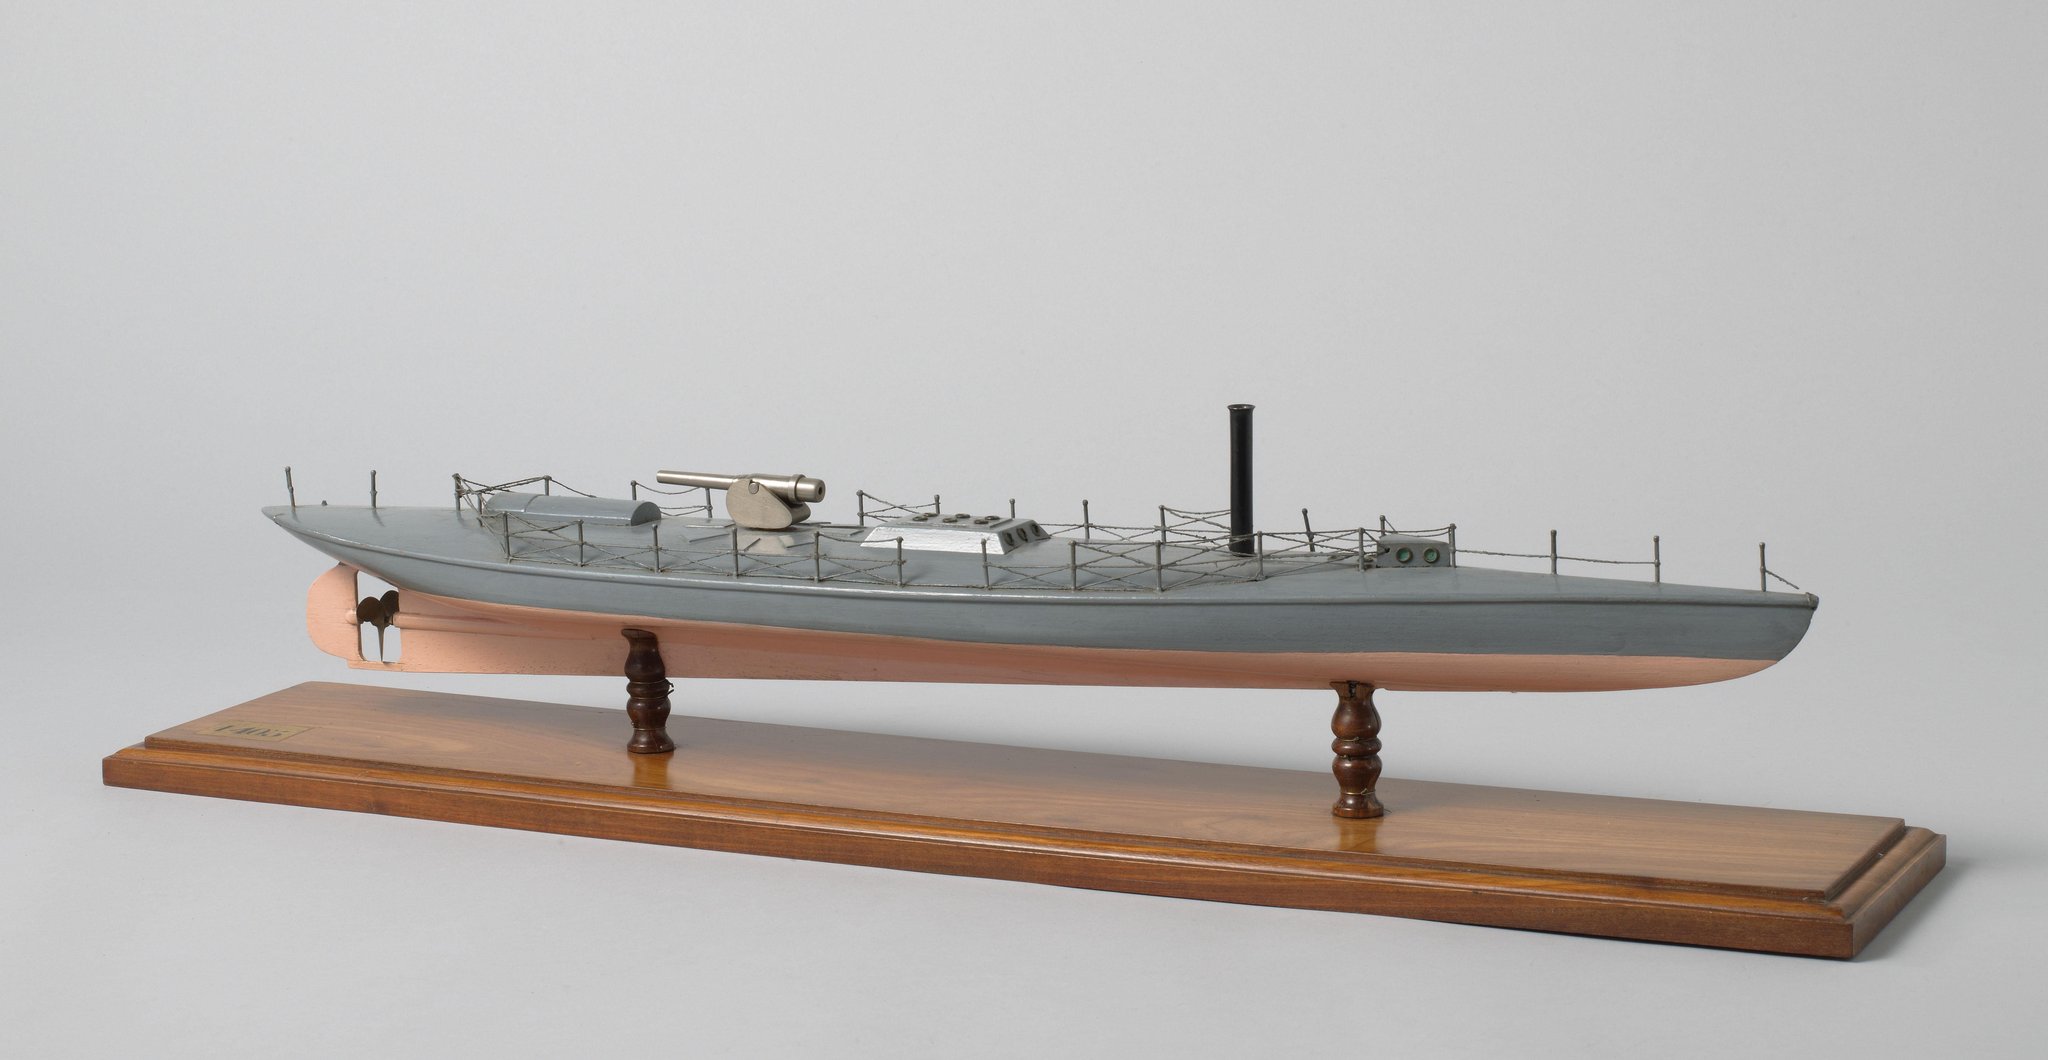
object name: ship model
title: Model of a Gunboat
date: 1877-1885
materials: brass, iron, wood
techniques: polychromy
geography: essen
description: Gepolychromeerd blokmodel op een grondplank. Het is een zeer gestroomlijnd en slank schip, met een S-spant die naar het achterschip steeds dieper steekt. Scherpe kano-achtige voorsteven, scherp kruiserhek, roer met afgerond roerblad, een driebladige schroef. Het dek loopt af naar de zijden, het middengedeelte ervan is omringd door een reling; drie zeer lage dekopbouwen, een kanon à pivot op het breedste punt van het schip, een schoorsteen voor.